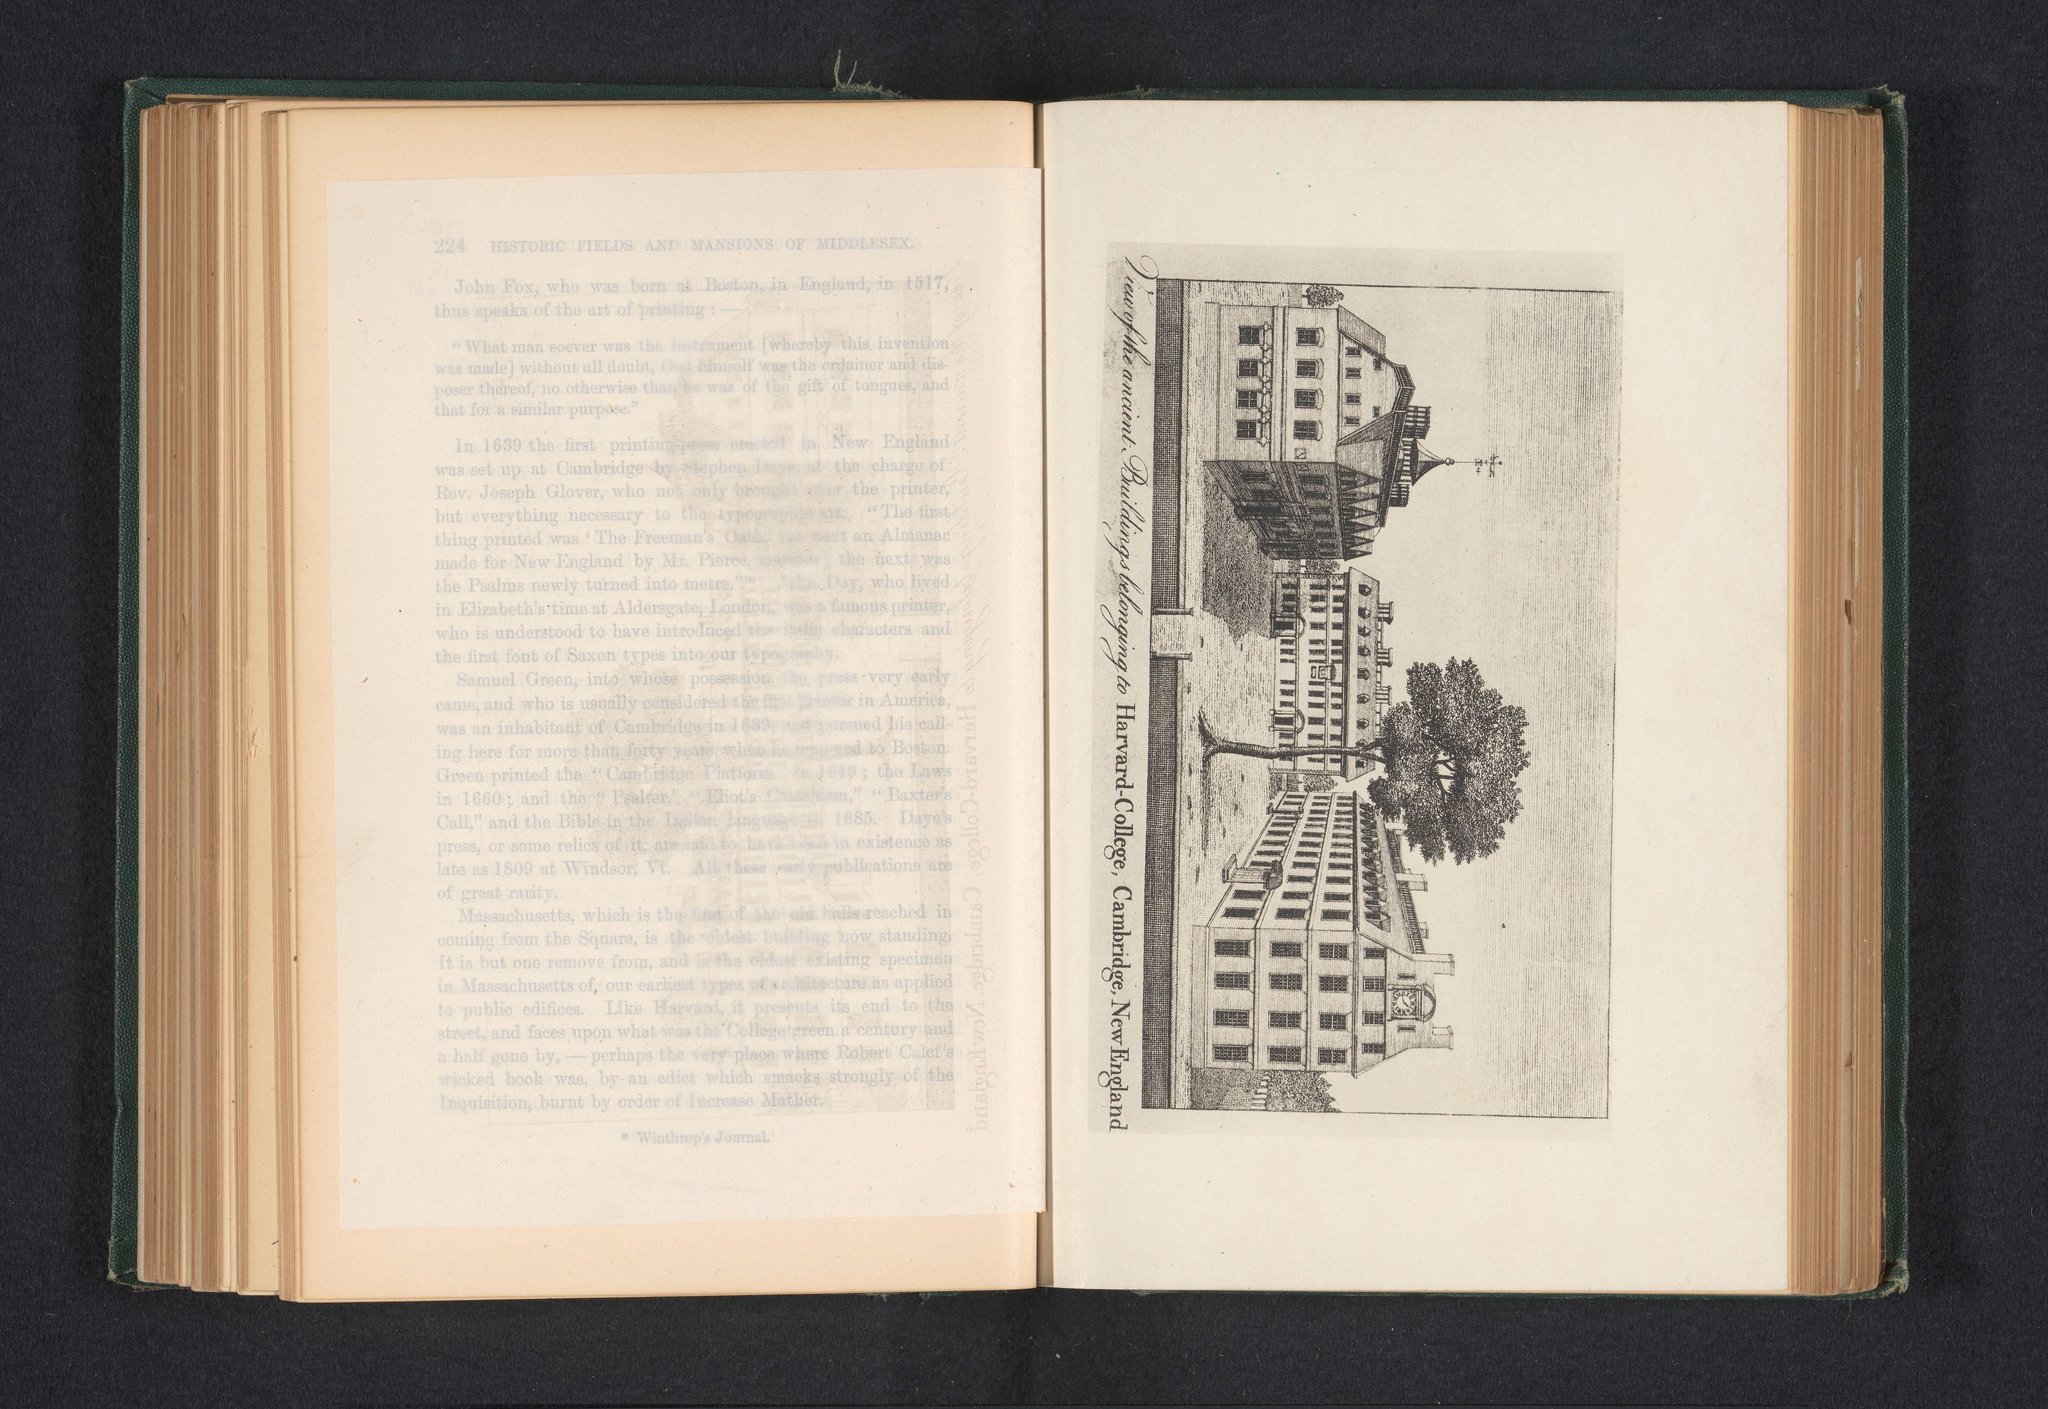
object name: page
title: View of the ancient buildings belonging to Harvard-College, Cambridge, New England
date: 1869-1874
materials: paper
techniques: photograph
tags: university, façade (of house or building)